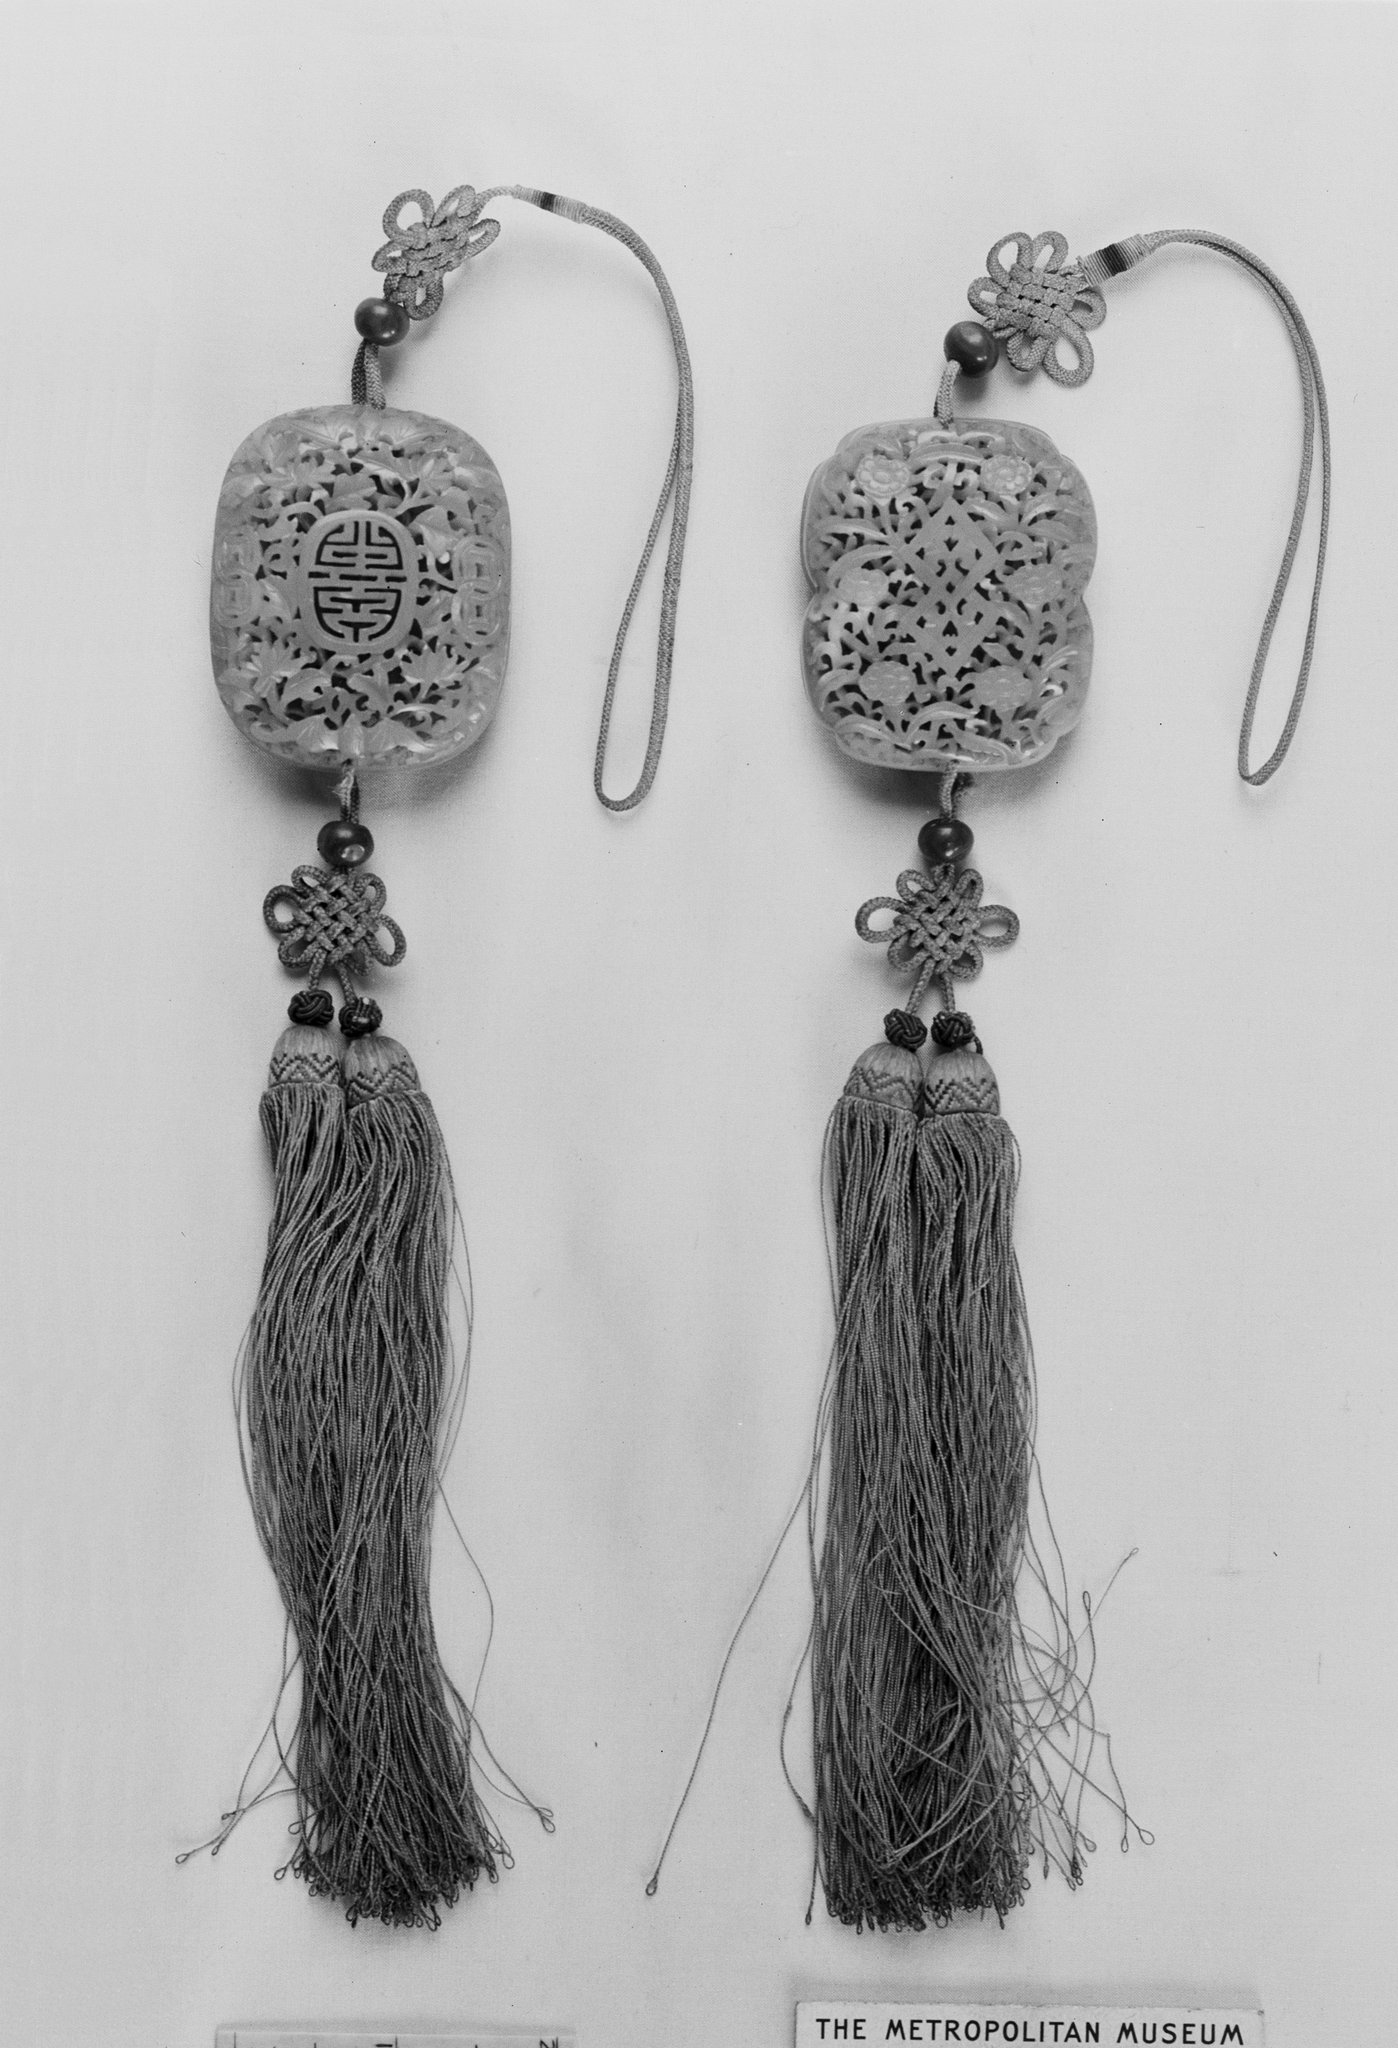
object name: perfume receptacle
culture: chinese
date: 1736-1795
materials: jade